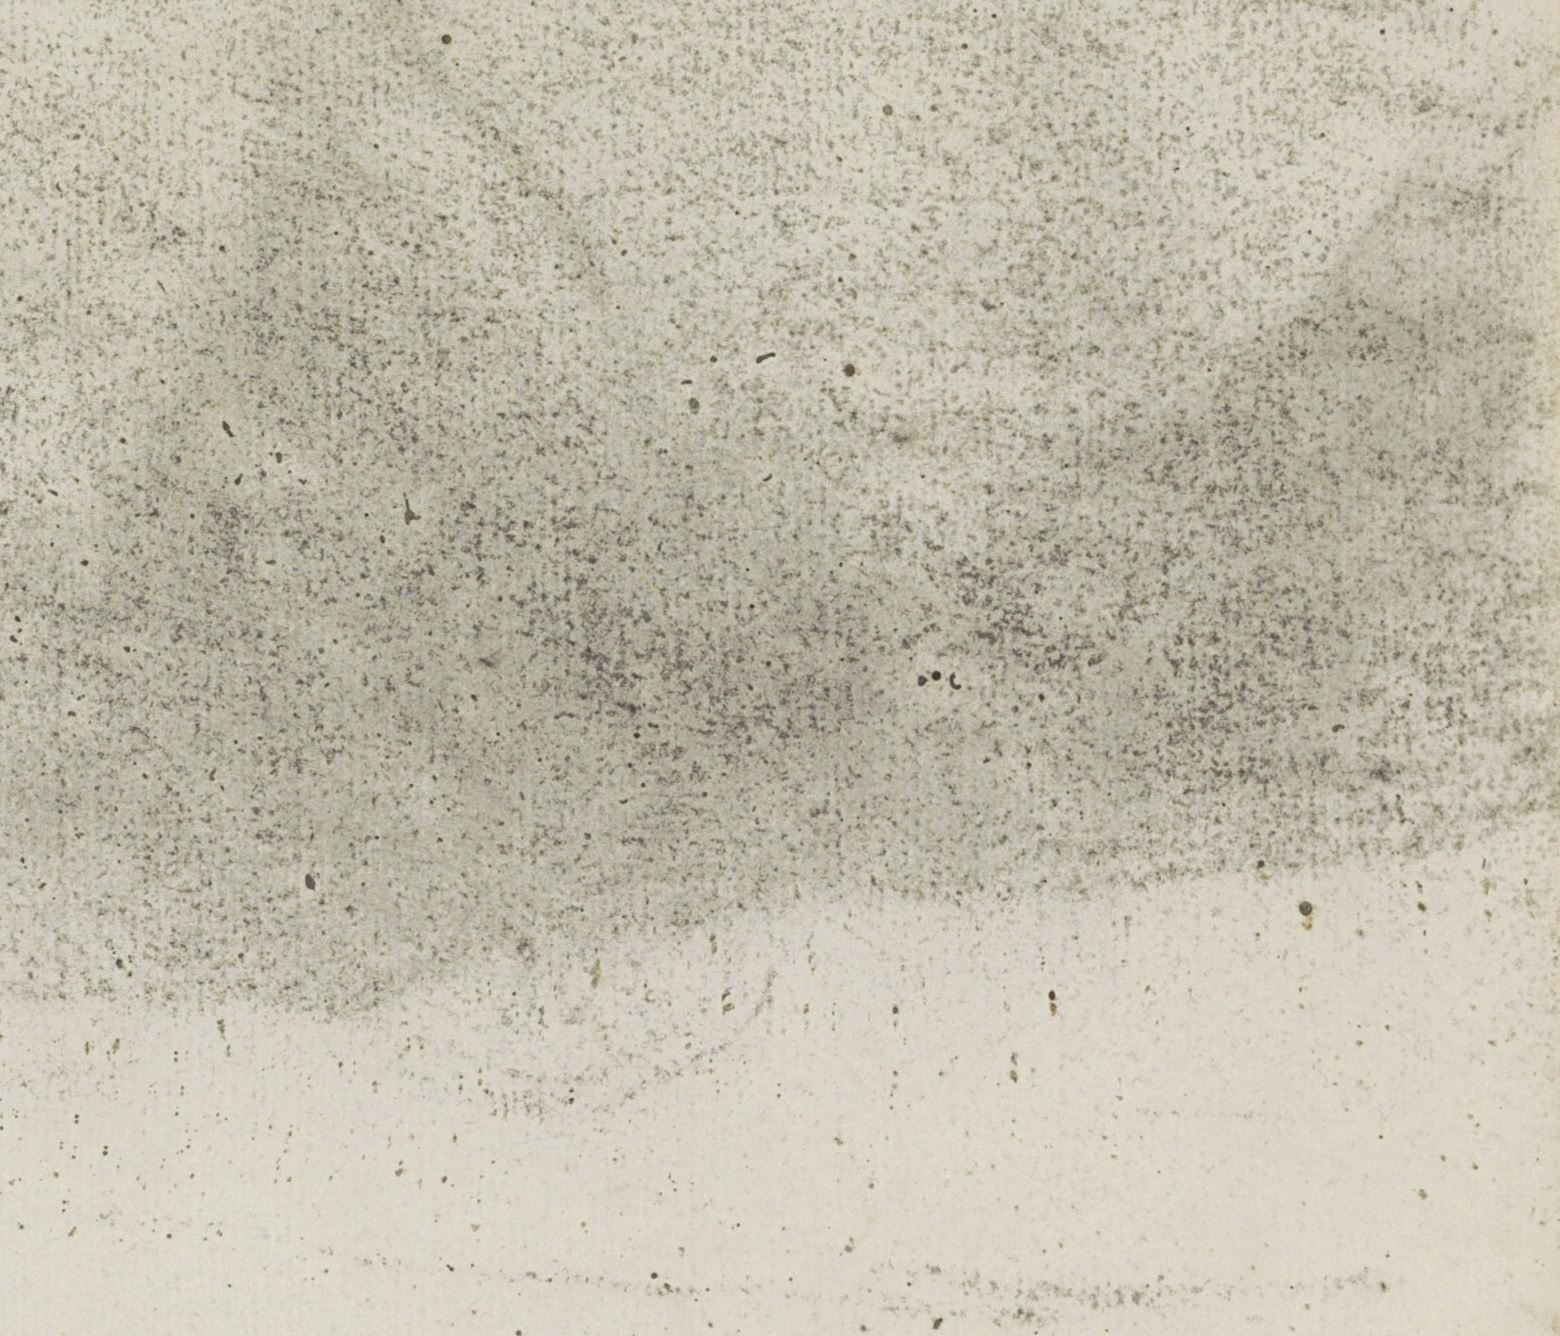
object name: sketchbook leaf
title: Abklatsch van de krijttekening op blad 6 verso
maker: willem witsen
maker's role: draughtsman, painter, print maker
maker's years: 1860-1923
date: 1915-1920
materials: paper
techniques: printmaking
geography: amsterdam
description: Blad 7 recto uit een schetsboek met 12 bladen.